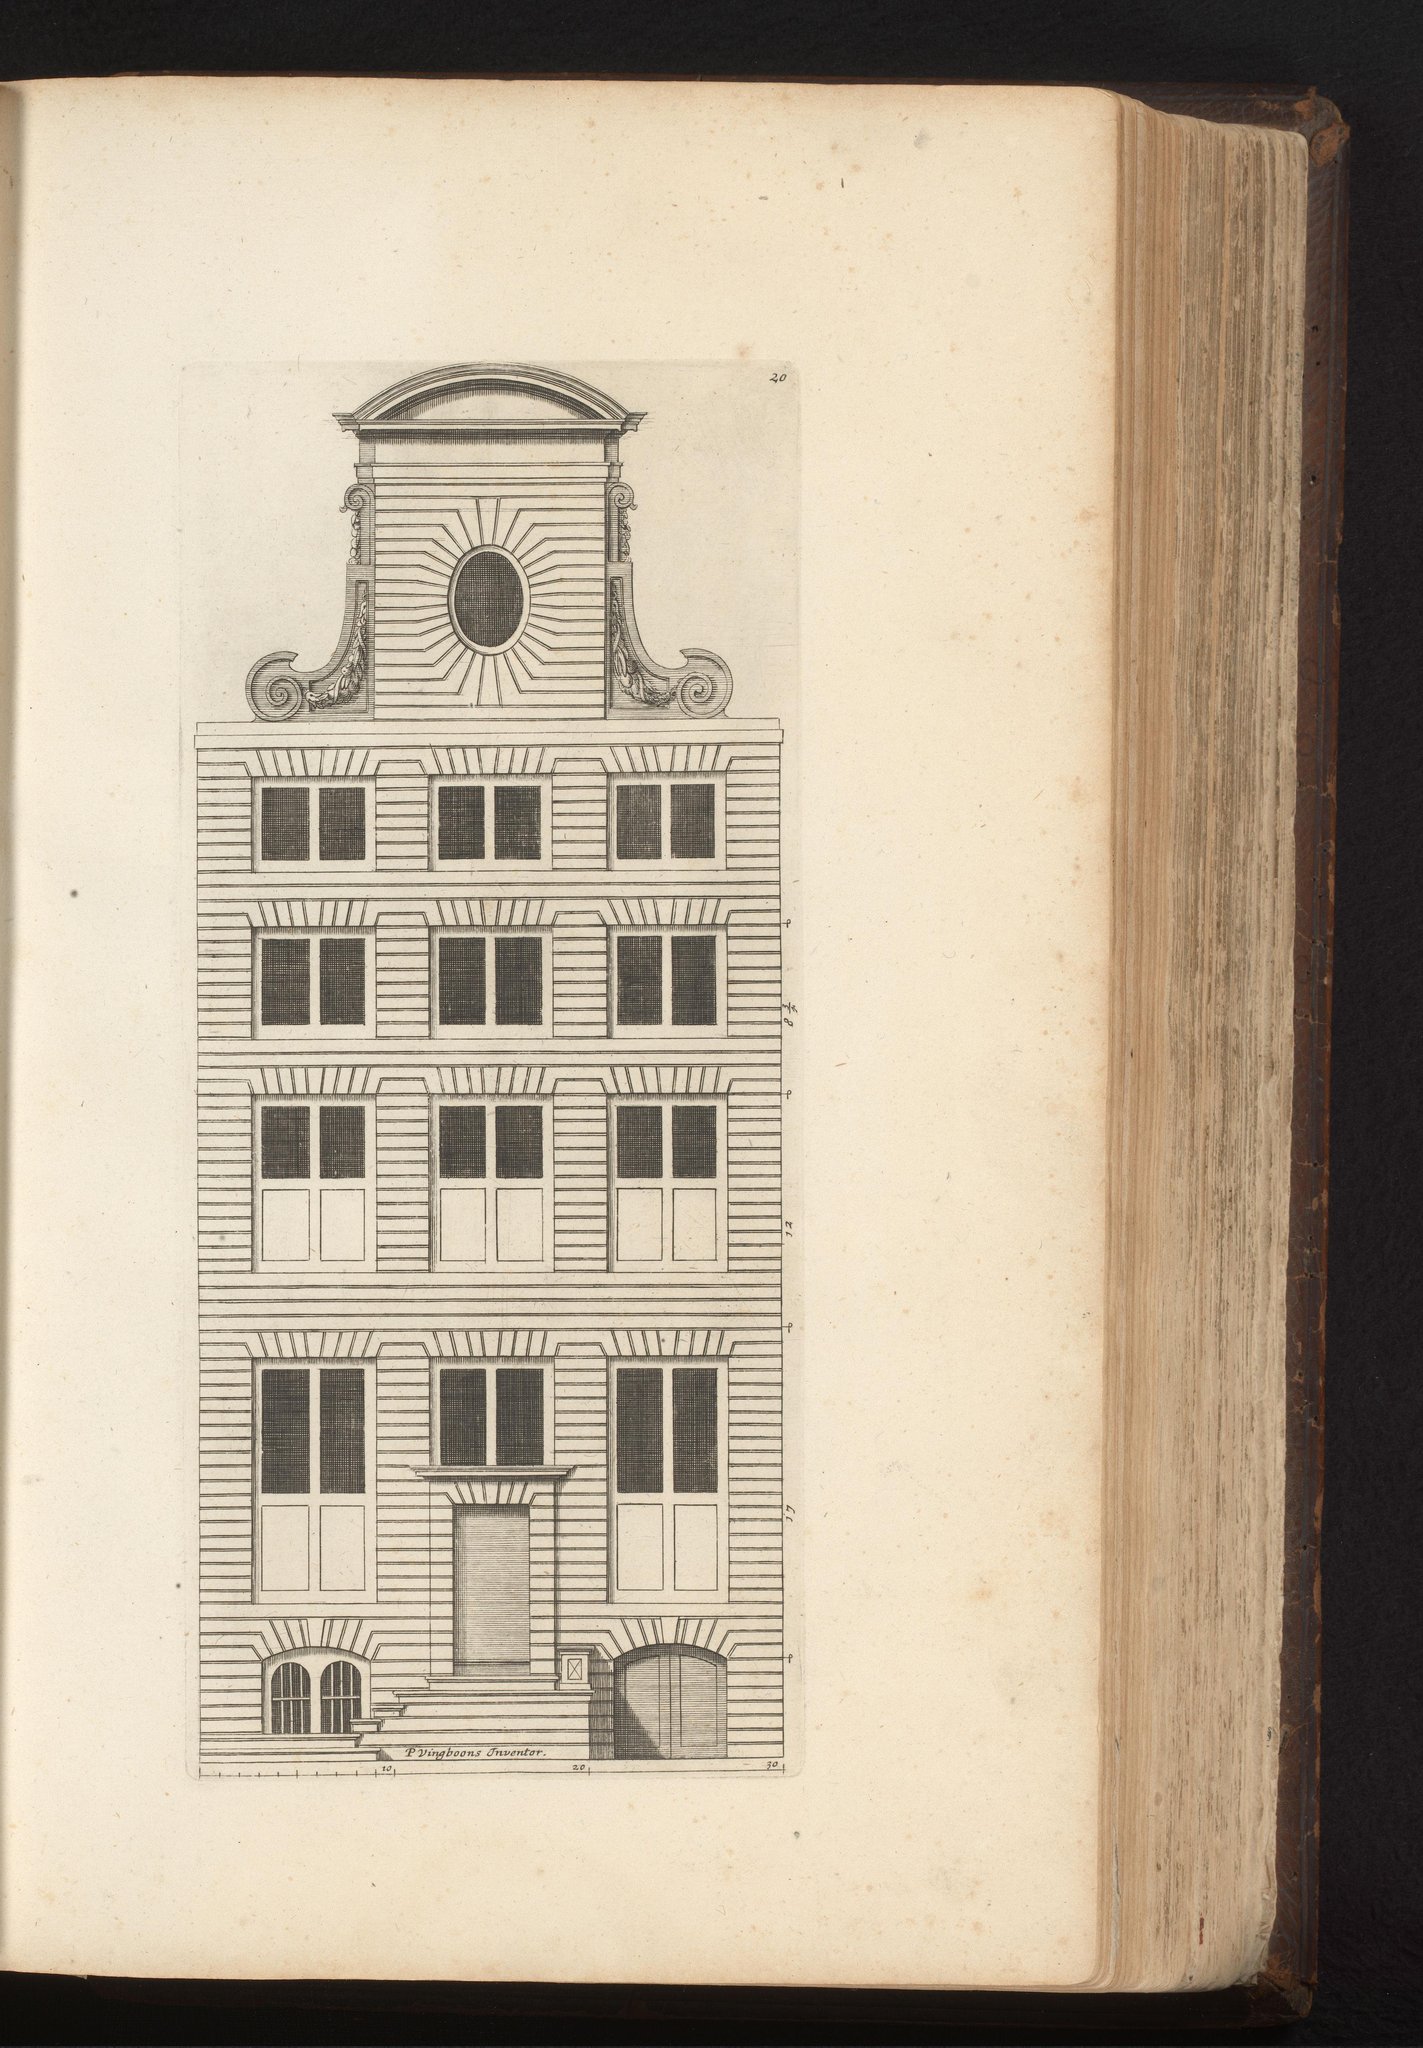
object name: book illustration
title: Gevel voor een herenhuis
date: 1648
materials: paper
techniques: engraving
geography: amsterdam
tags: urban housing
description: Prent uit: Afbeelsels der voornaemste gebouwen uyt alle die Philips Vingboons geordineert heeft. Amsterdam: Philips en Johannes Vinckboons en Johannes Willemszoon Blaeu, 1648.